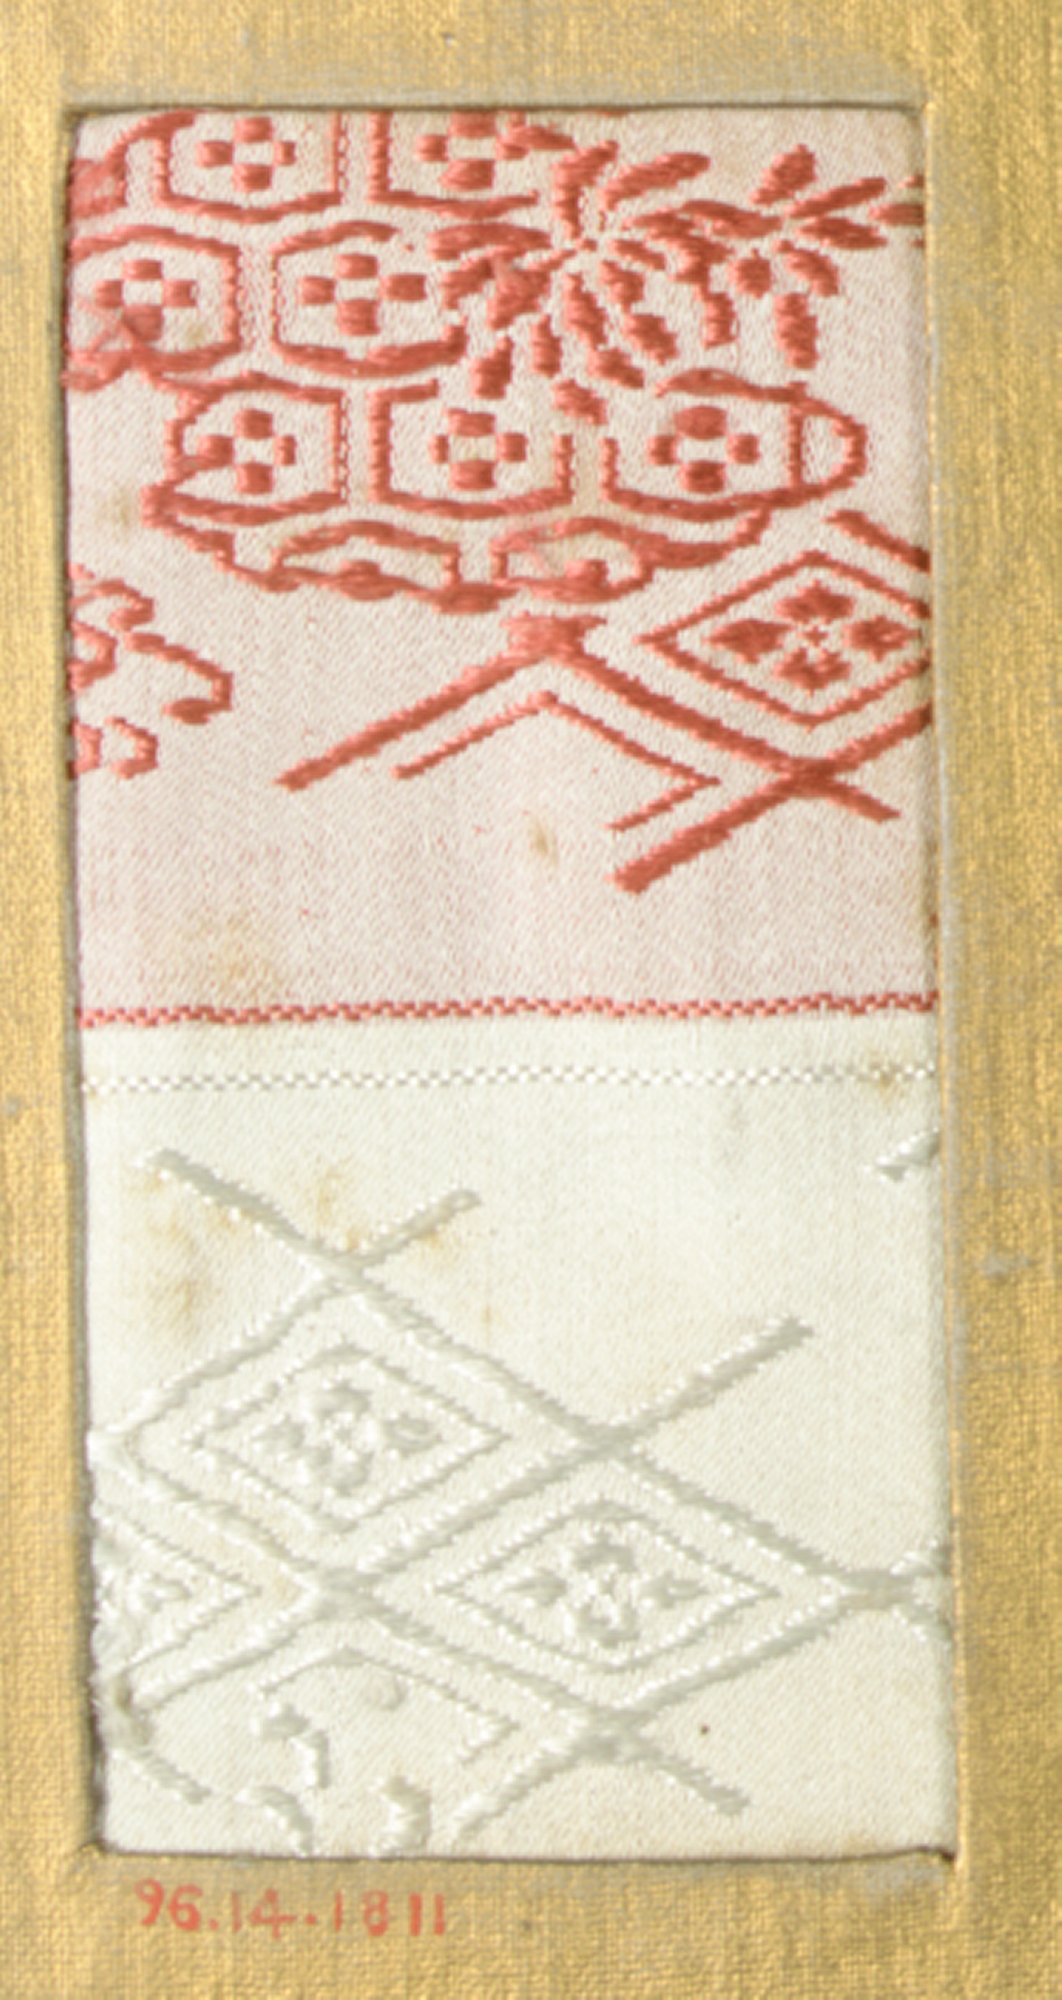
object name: piece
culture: japanese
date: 1701-1900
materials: silk